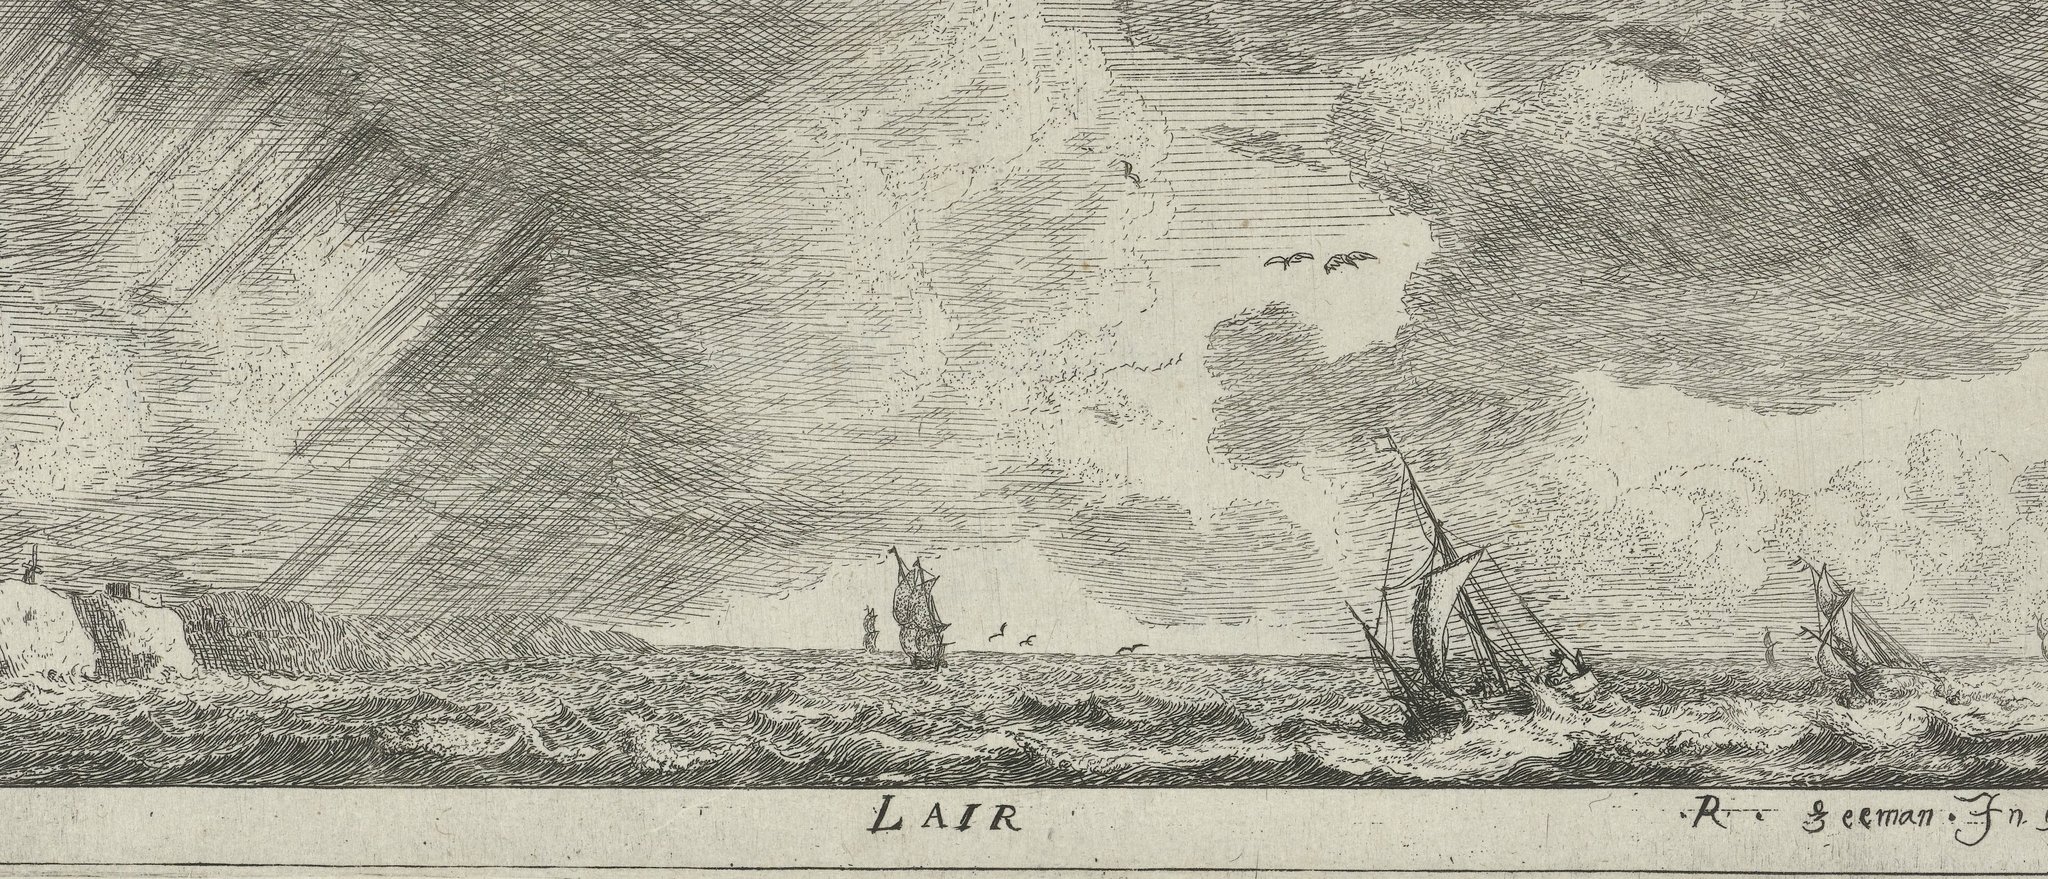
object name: print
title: L Air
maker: reinier nooms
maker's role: draughtsman, painter, print maker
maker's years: 1623-1664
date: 1651-1652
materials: paper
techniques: drypoint, etching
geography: netherlands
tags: air (one of the four elements), sea (seascape), nimbus, i.e. rain clouds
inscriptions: collector's mark: Lugt 2228a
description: Zeilschepen op een onrustige zee vlakbij een kust met windmolens. In de lucht cumulus wolken en een regenbui.